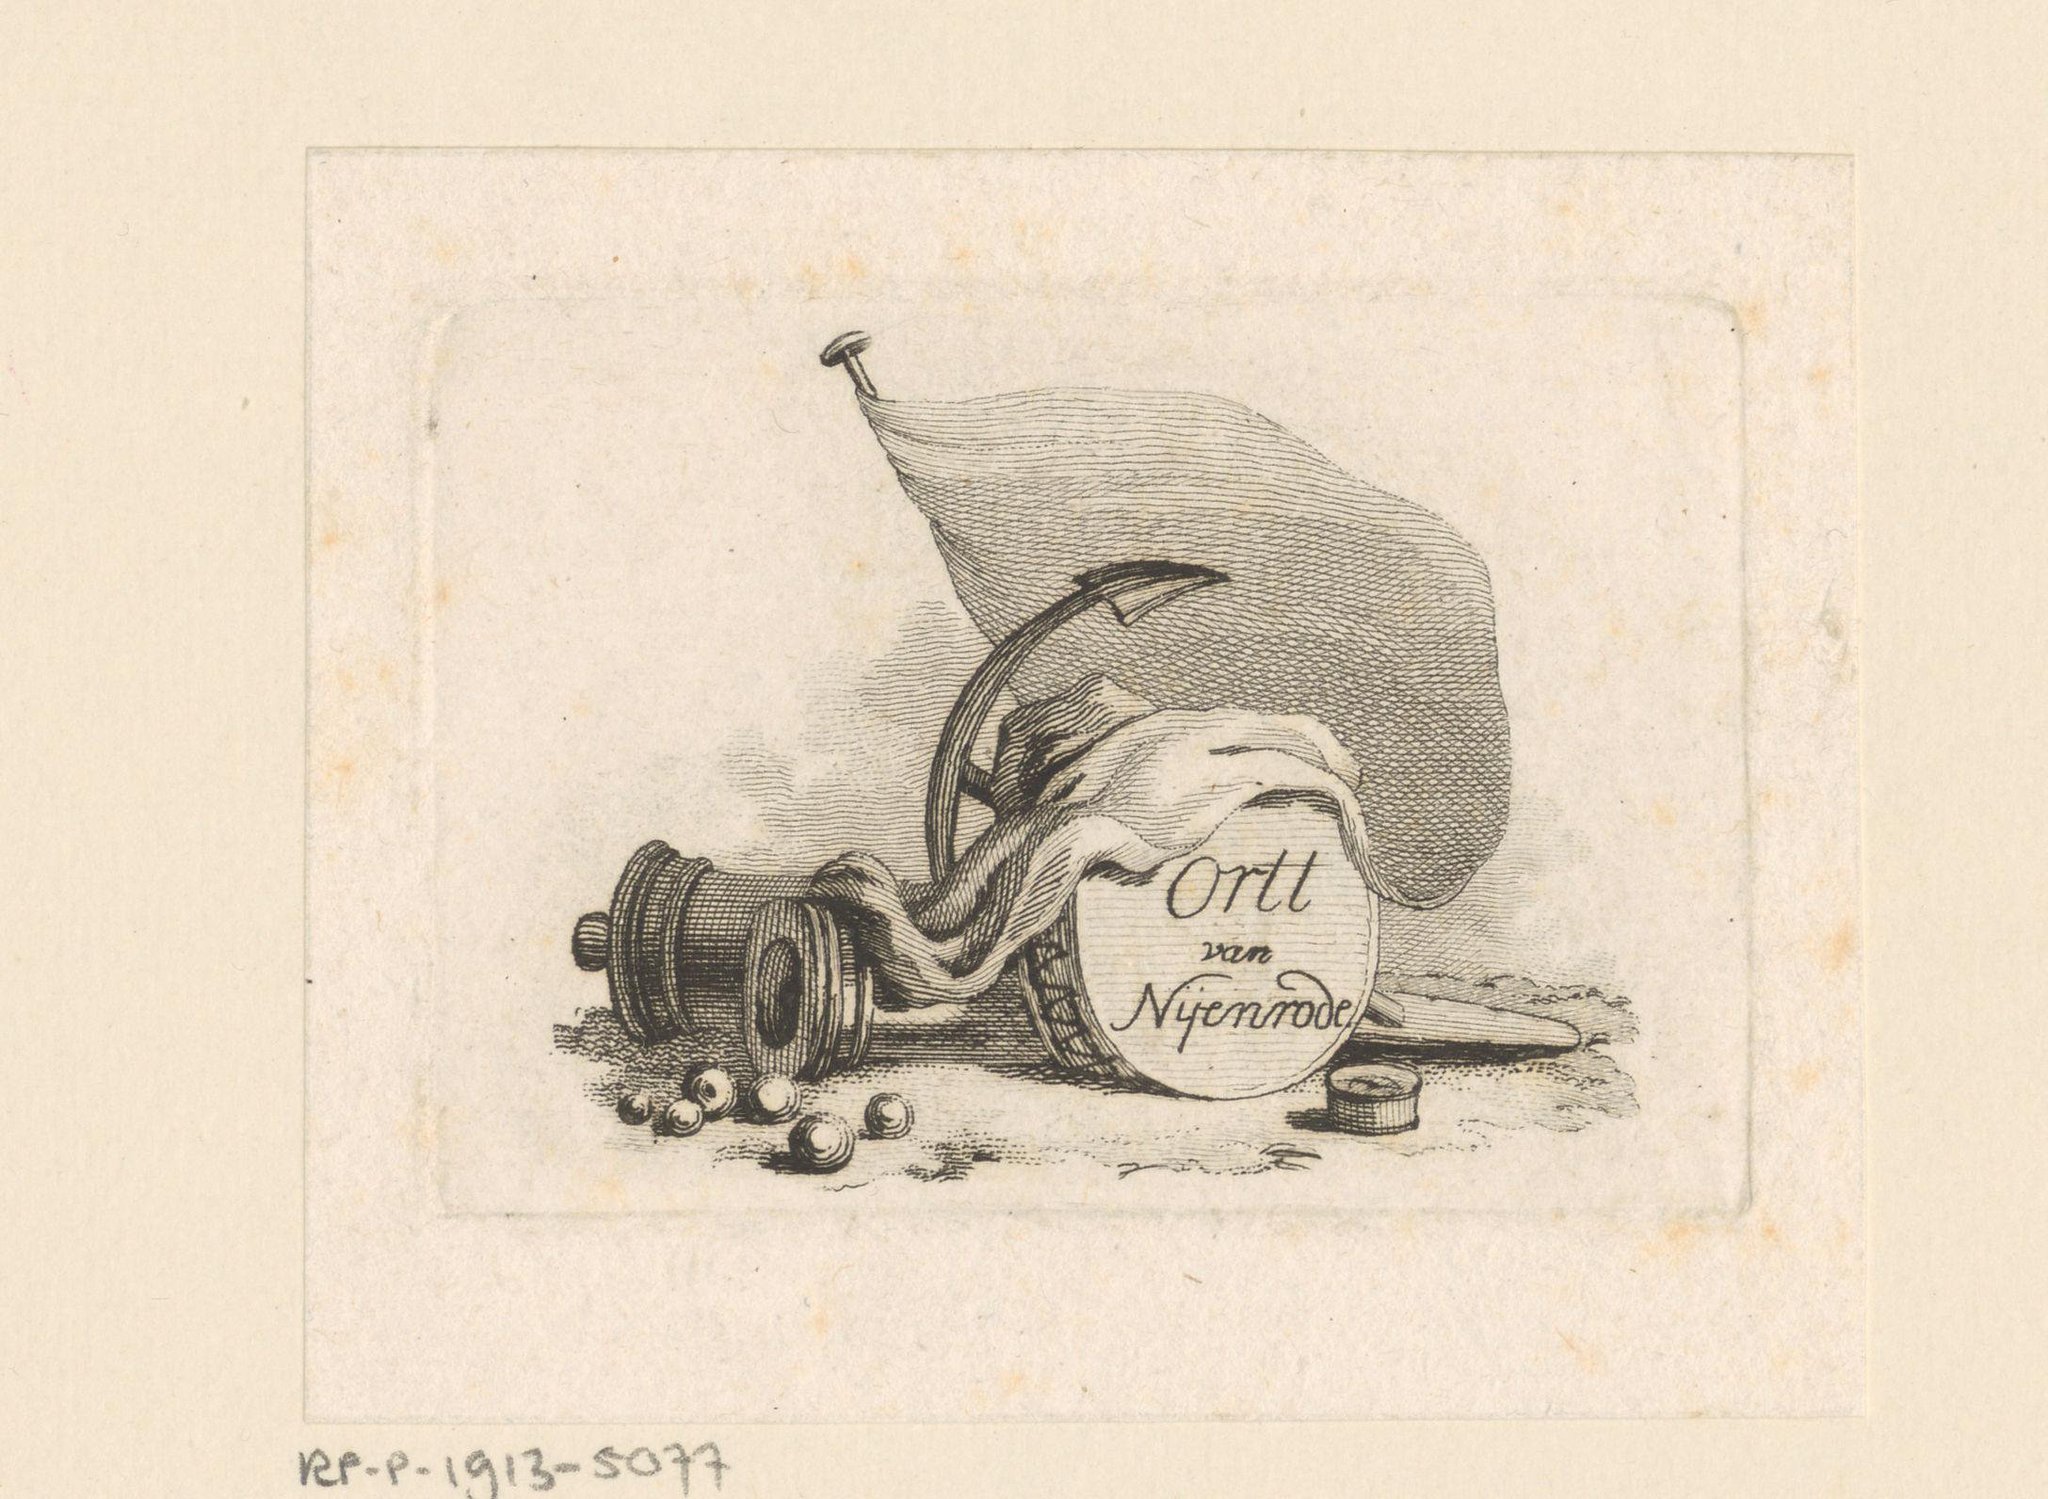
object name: bookplate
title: Ex libris van Ortt van Nijenrode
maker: Anonymous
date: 1800-1899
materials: paper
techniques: etching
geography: netherlands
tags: drum (musical instrument), firearms: cannon, flags (~ signalling), parts of ship's exterior: anchor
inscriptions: collector's mark: Lugt 2760, collector's mark: Lugt 2233